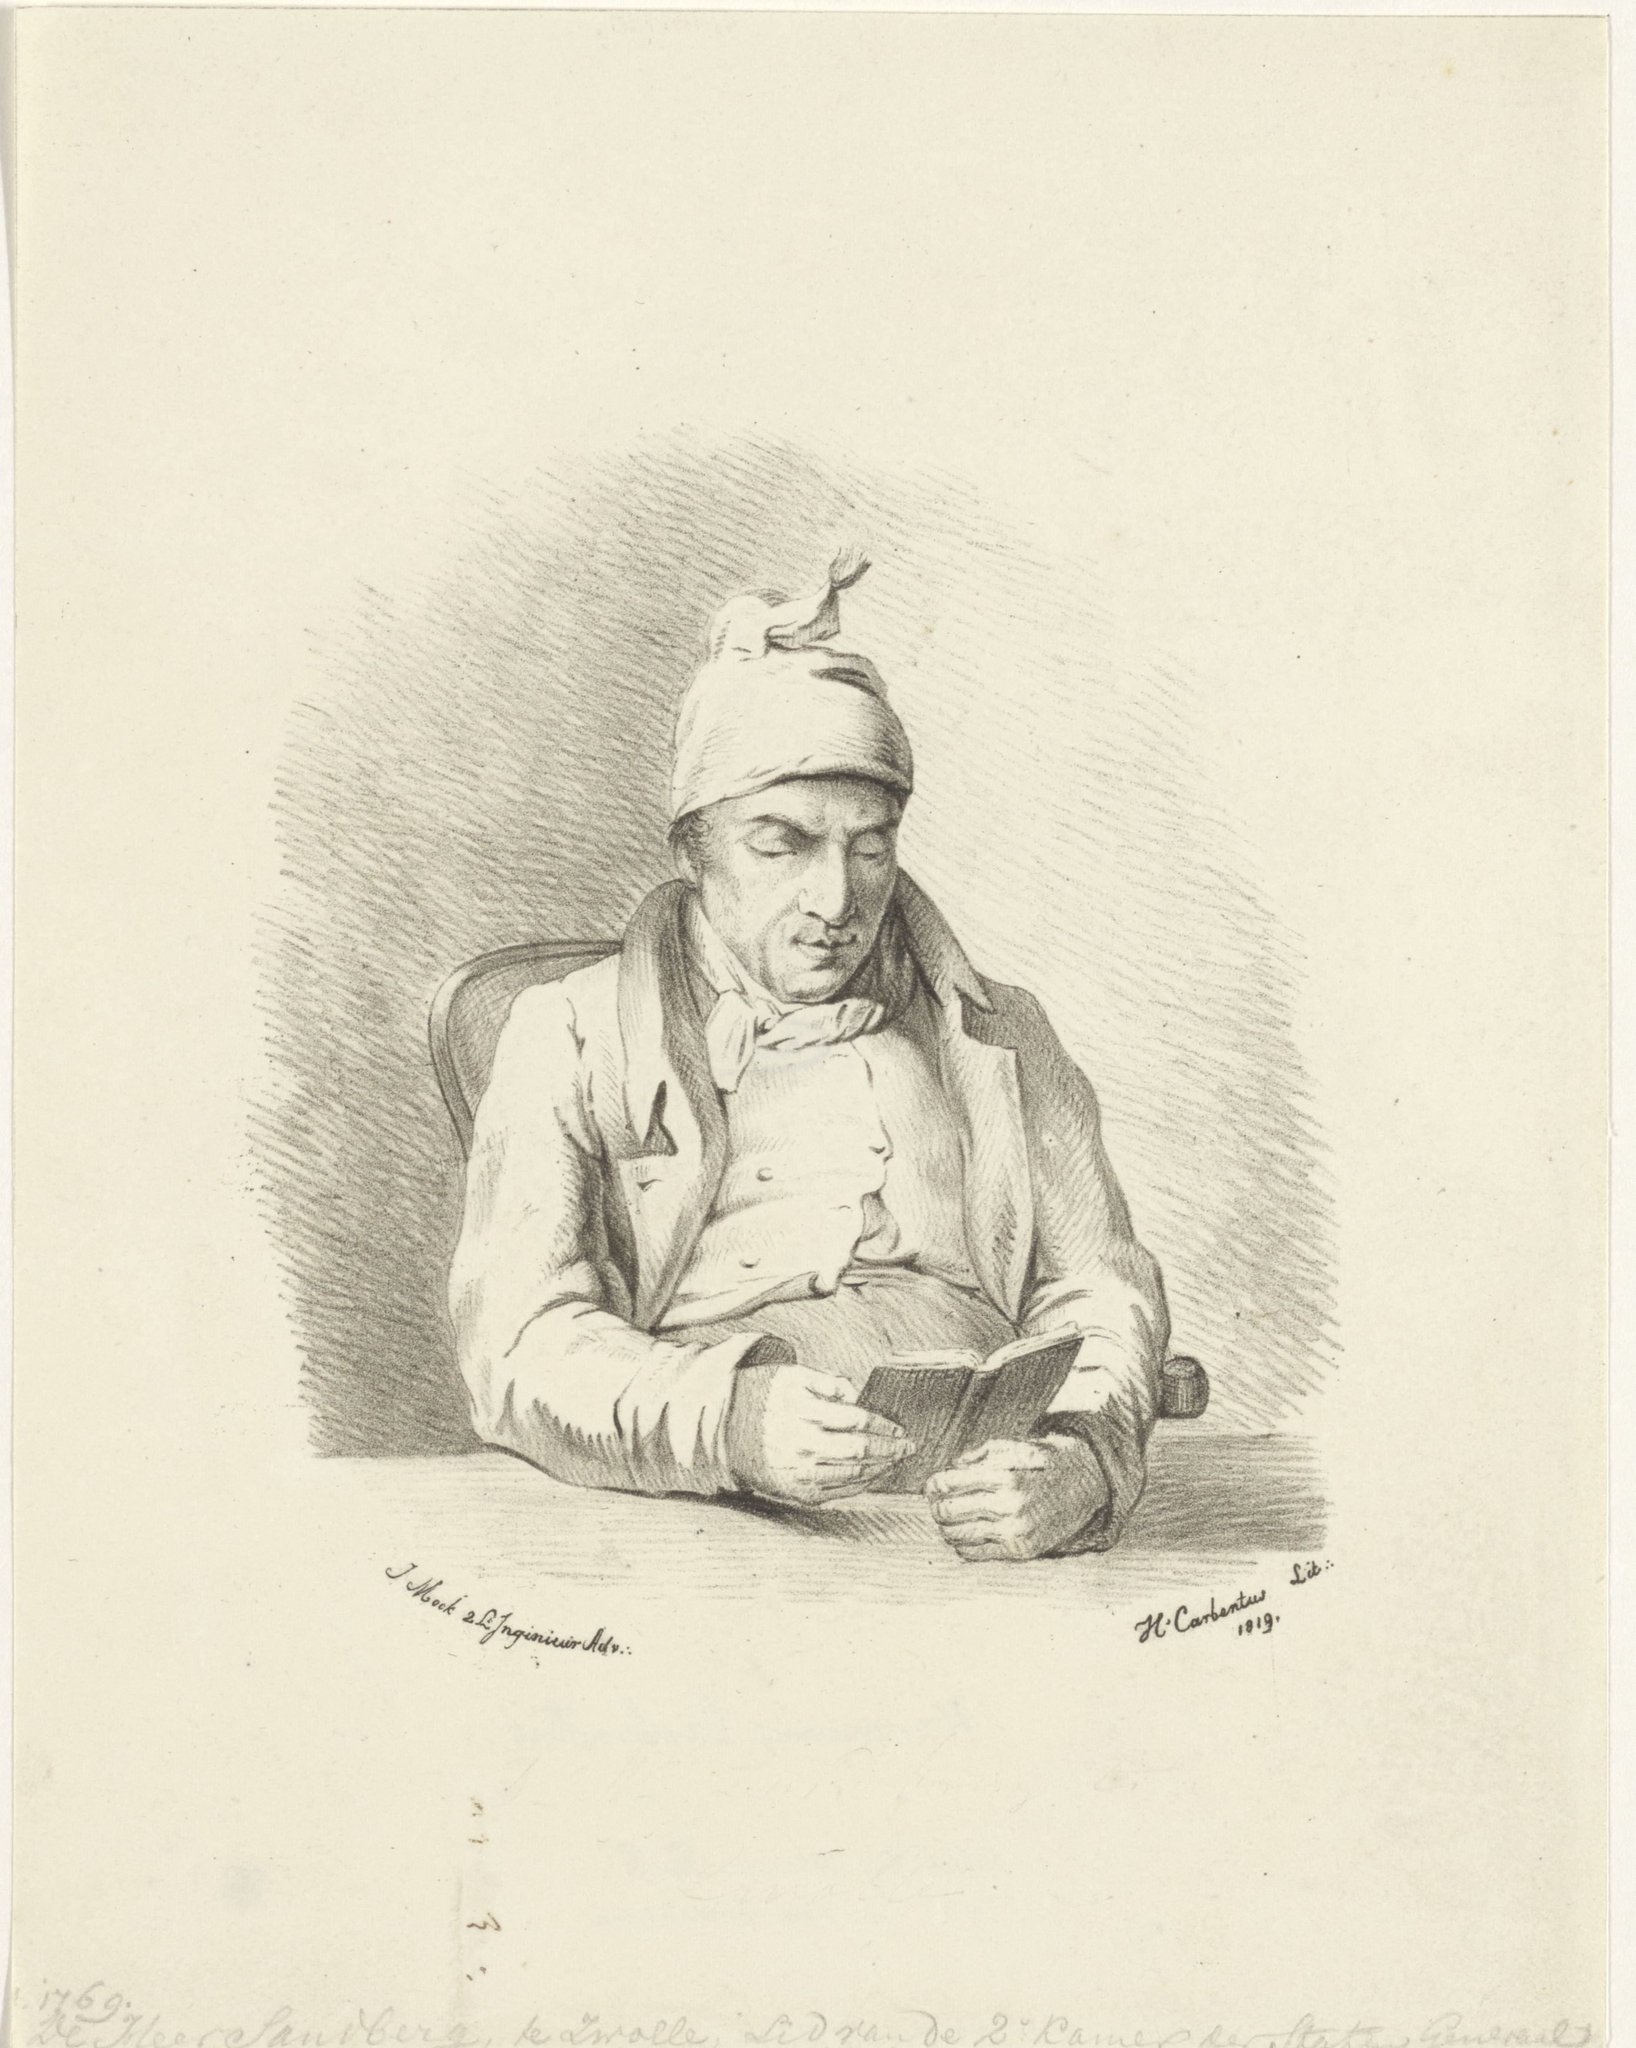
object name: print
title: Portret van A. Sandberg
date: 1819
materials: paper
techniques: lithograph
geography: the hague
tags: reading, head-gear: morning cap, historical persons (+ (full) bust portrait)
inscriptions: inscription: ‘1769 / De heere Sandberg, te Zwolle, lid van de 2e kamer der Staate Generaal.’, collector's mark: Lugt 2760, collector's mark: Lugt 2228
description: De geportretteerde zit aan tafel en leest een boek. Hij draagt een slaapmuts.